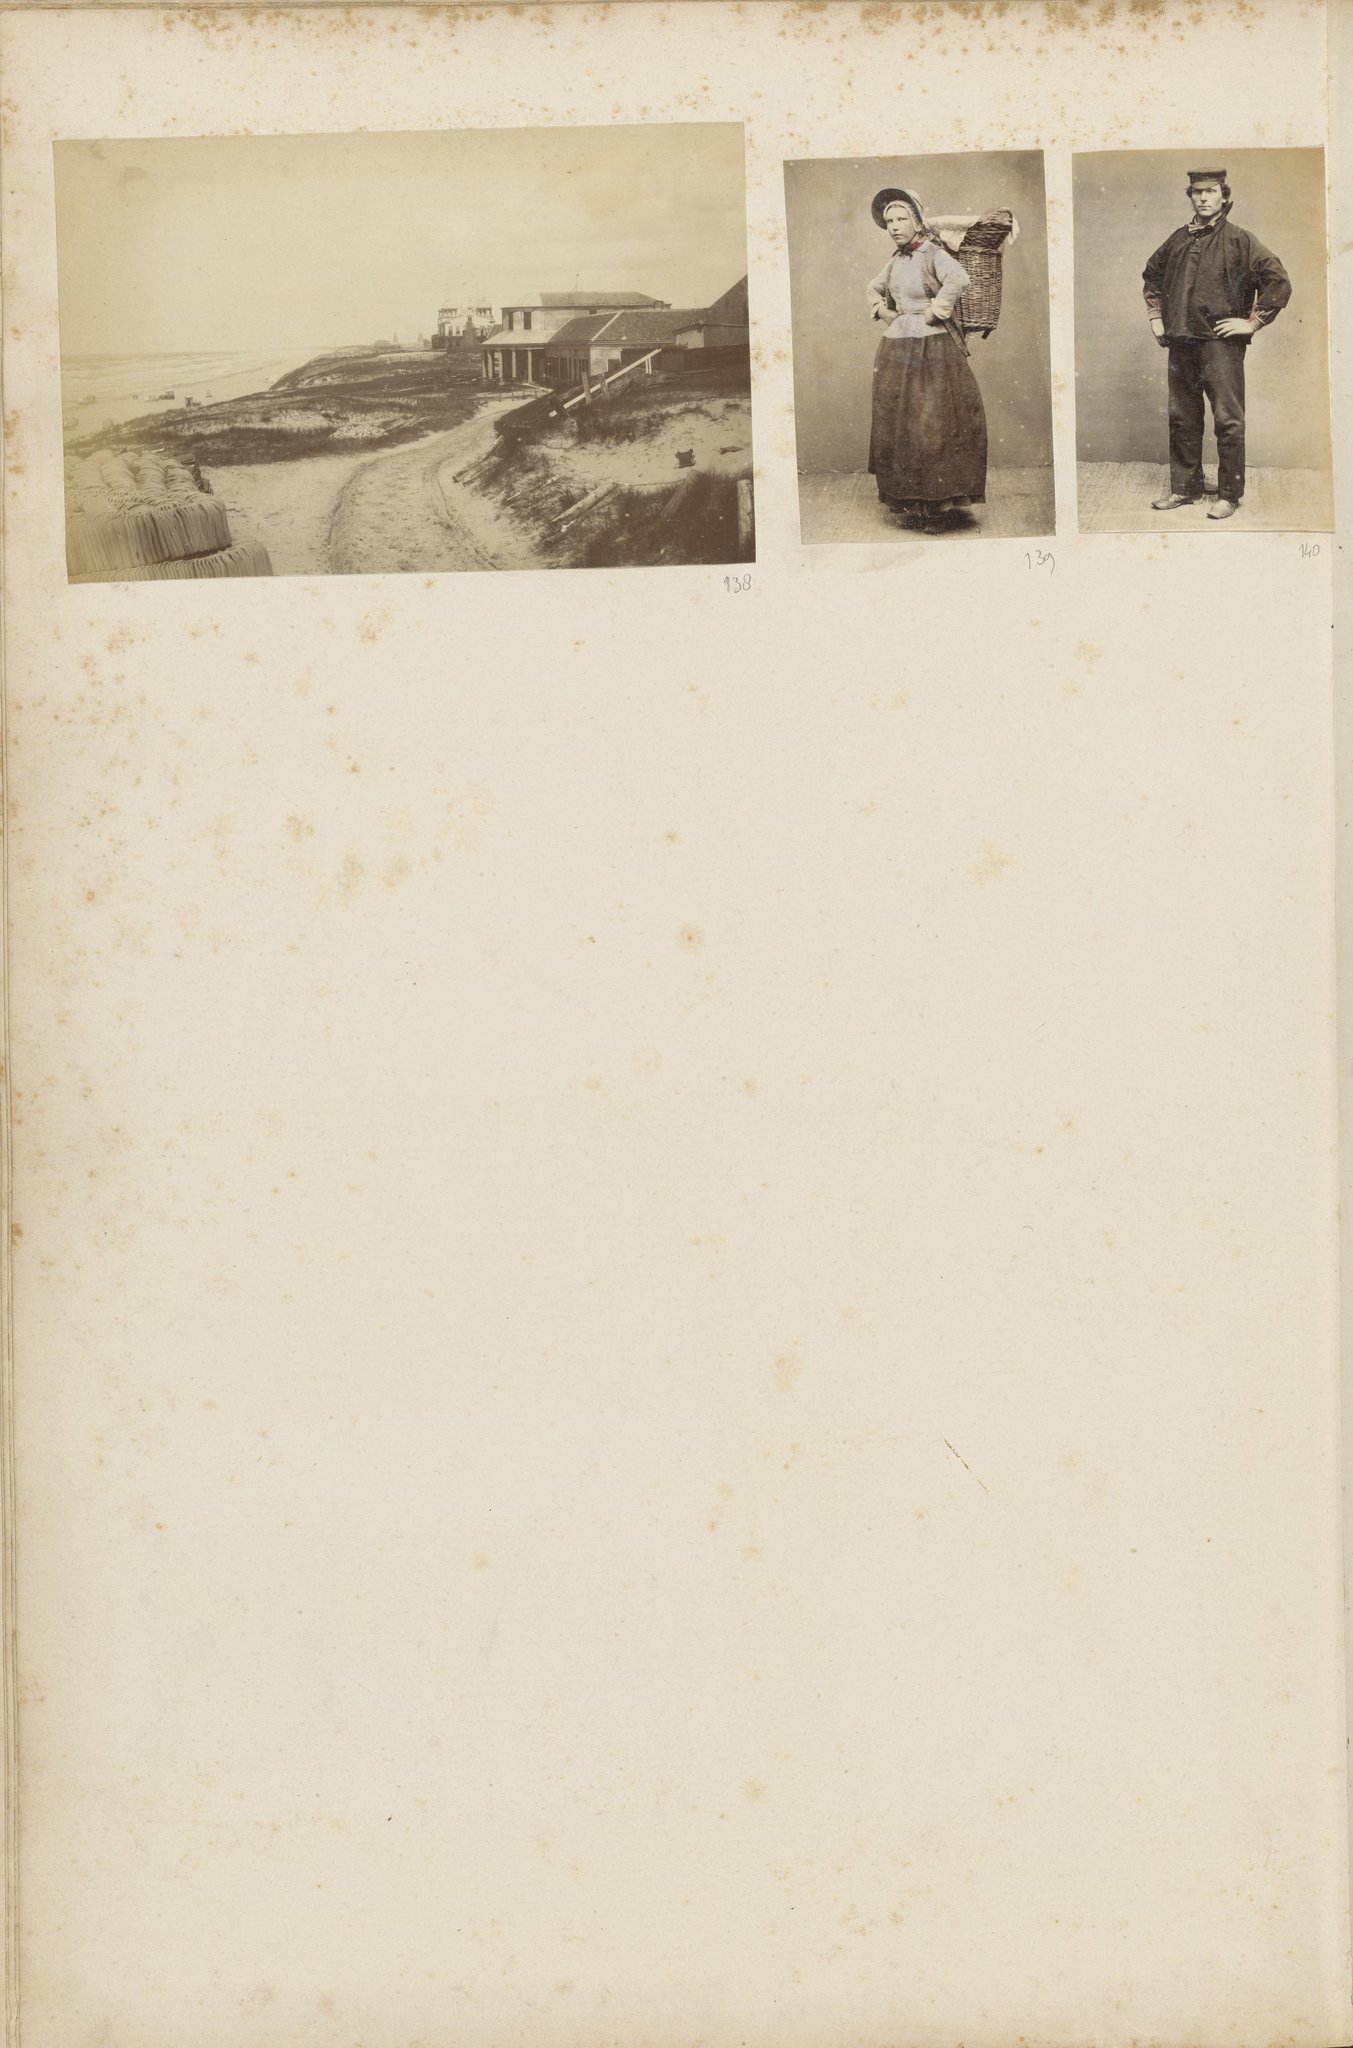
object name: photograph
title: Portret van een vrouw in (mogelijk) Zandvoortse klederdracht met mand op de rug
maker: Anonymous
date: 1870-1880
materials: paper, photographic support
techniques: albumen print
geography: netherlands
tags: folk costume, regional costume, netherlands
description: Onderdeel van Fotoalbum van Robert Daniel Crommelin (1841-1907).